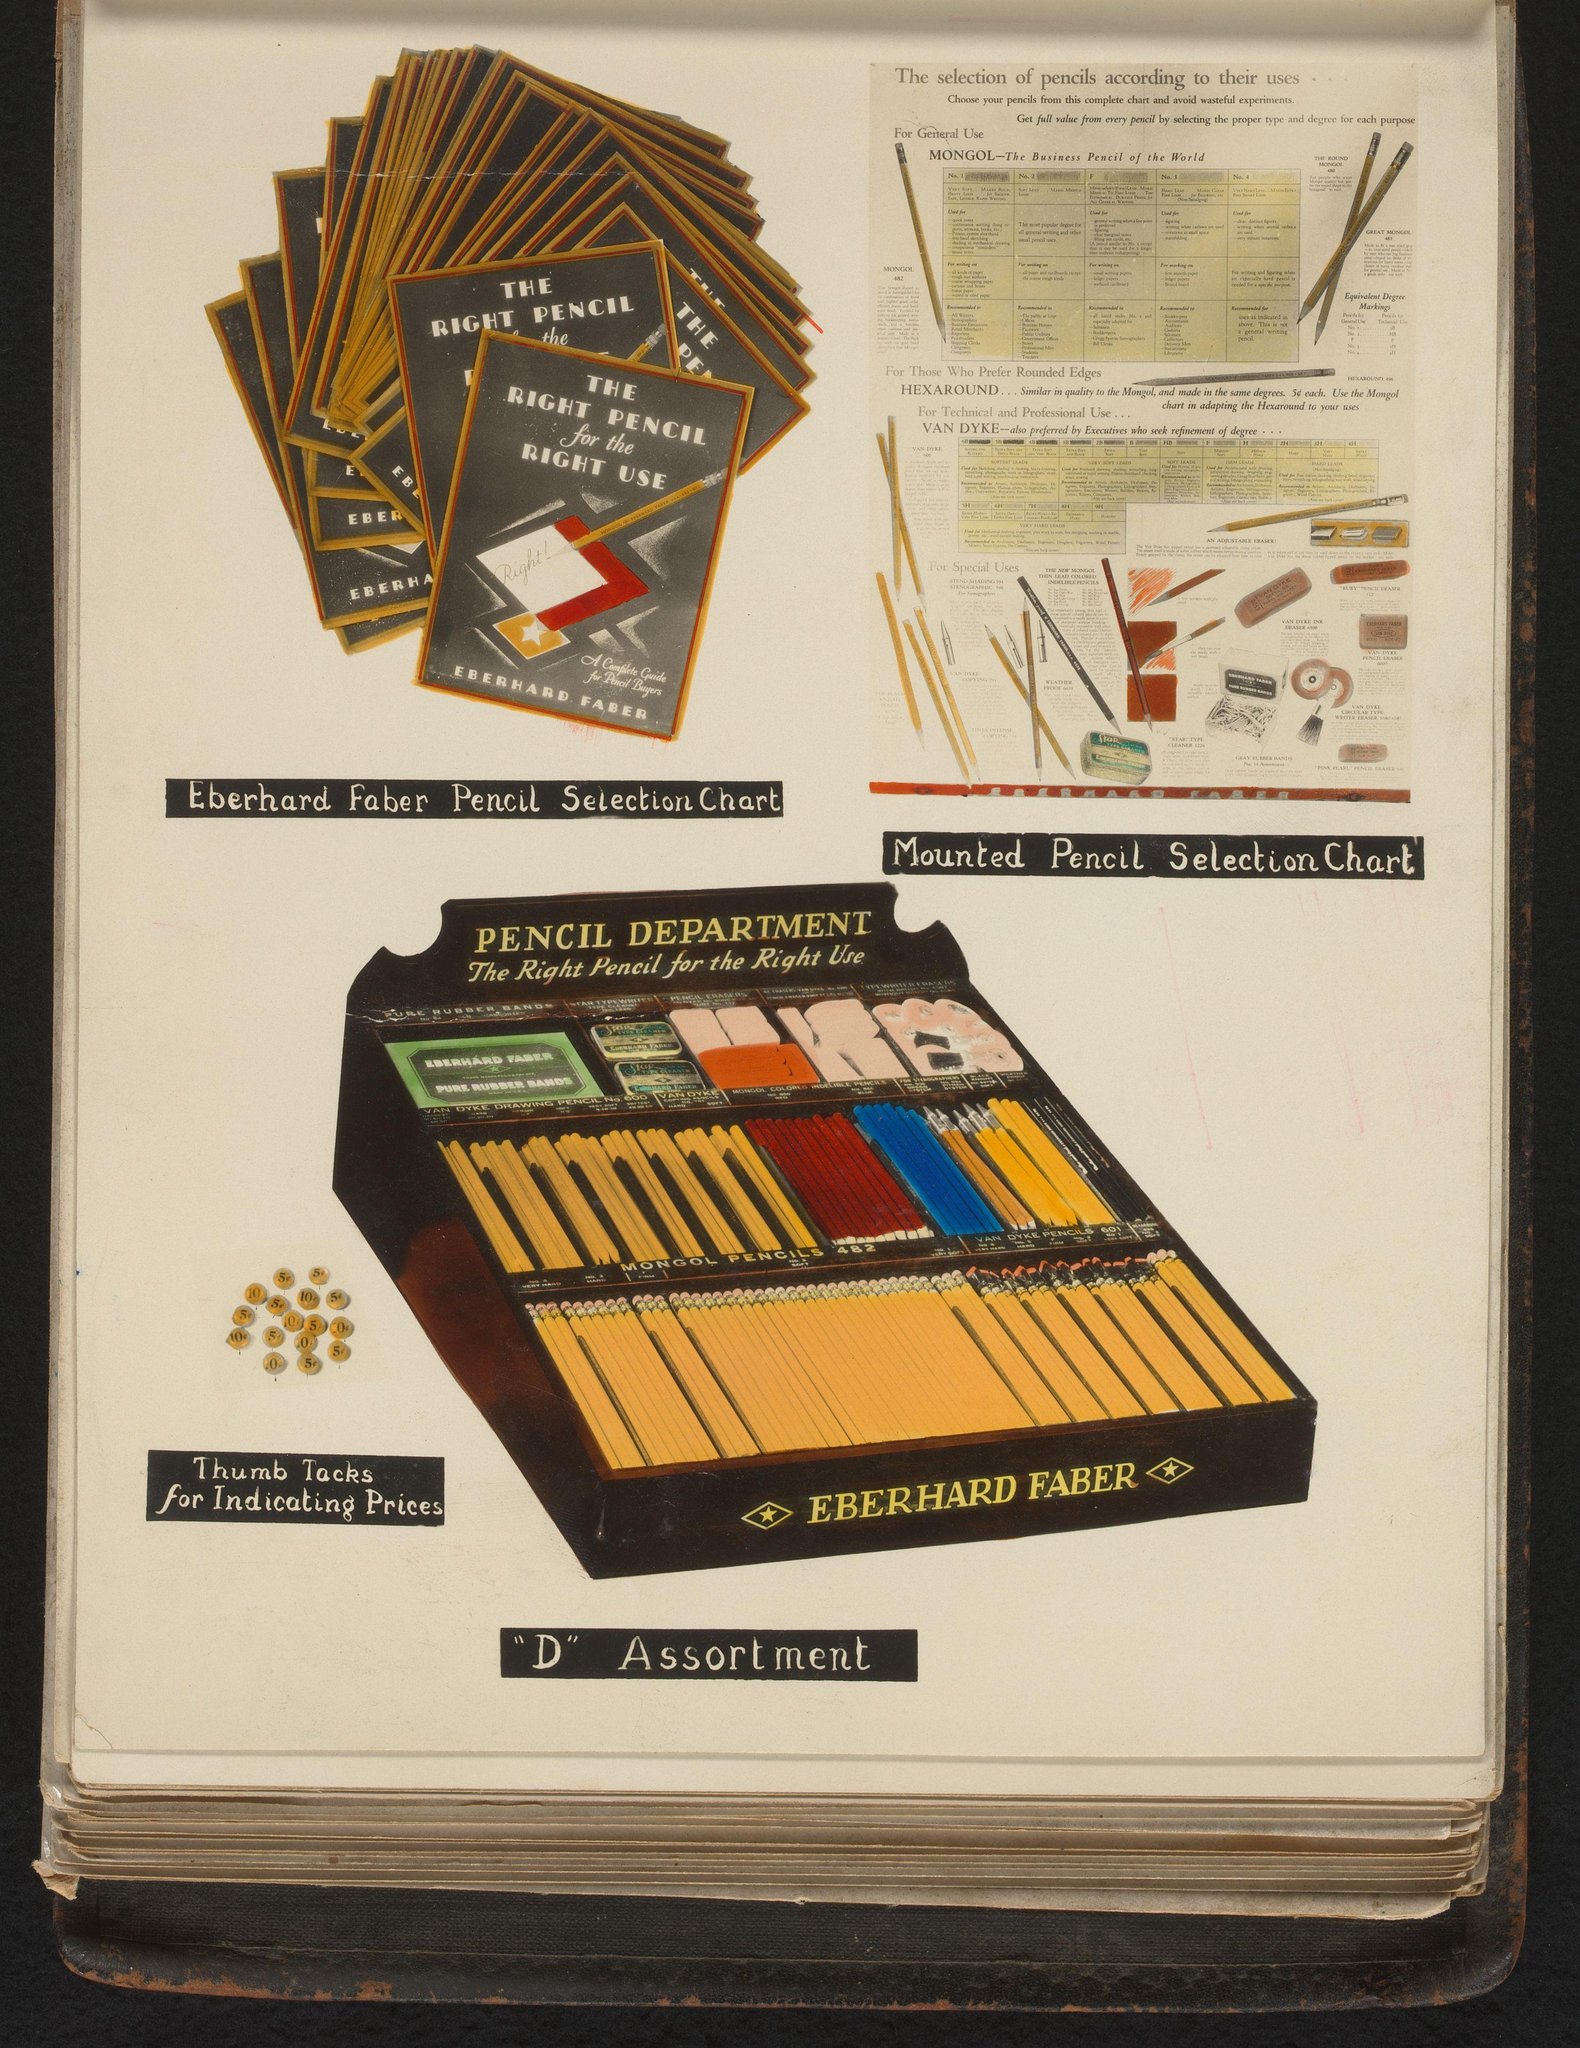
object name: photograph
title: Verkoopaccessoires voor potloden van Eberhard Faber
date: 1915-1935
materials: paper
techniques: gelatin silver print, hand coloring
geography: springfield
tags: pencil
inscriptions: stamp: ‘Paramount/ Commercial Studios/ 145 Chestnut St./ Springfield - Mass.’